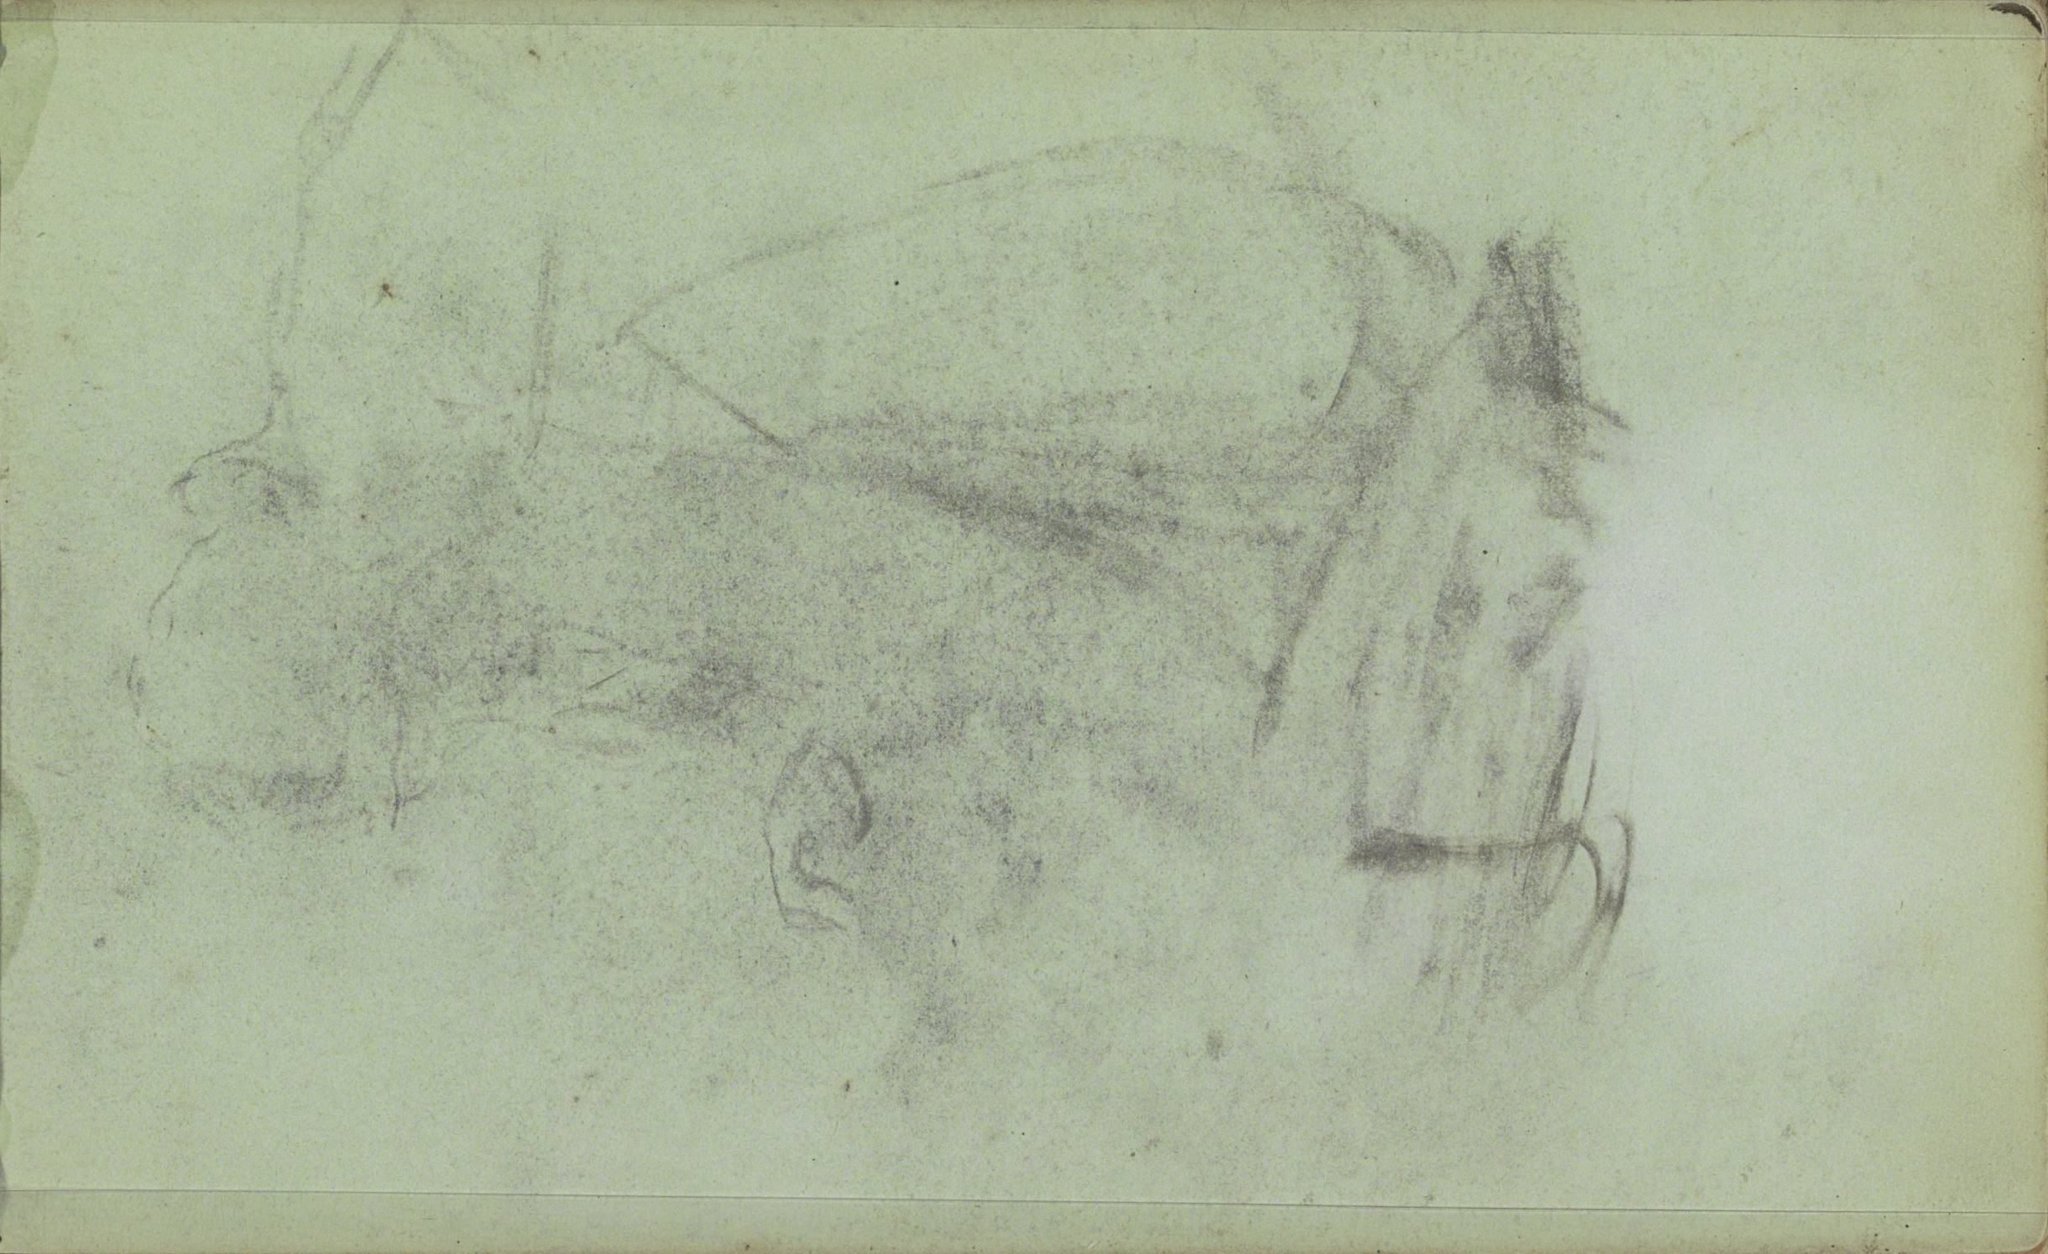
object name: sketchbook leaf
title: Figuurstudie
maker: jozef israëls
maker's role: draughtsman, painter, print maker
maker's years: 1824-1911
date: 1834-1911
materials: chalk, paper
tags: anatomy (non-medical)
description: Vermoedelijk een vrouw. Blad 21 recto uit een schetsboek met 42 bladen.